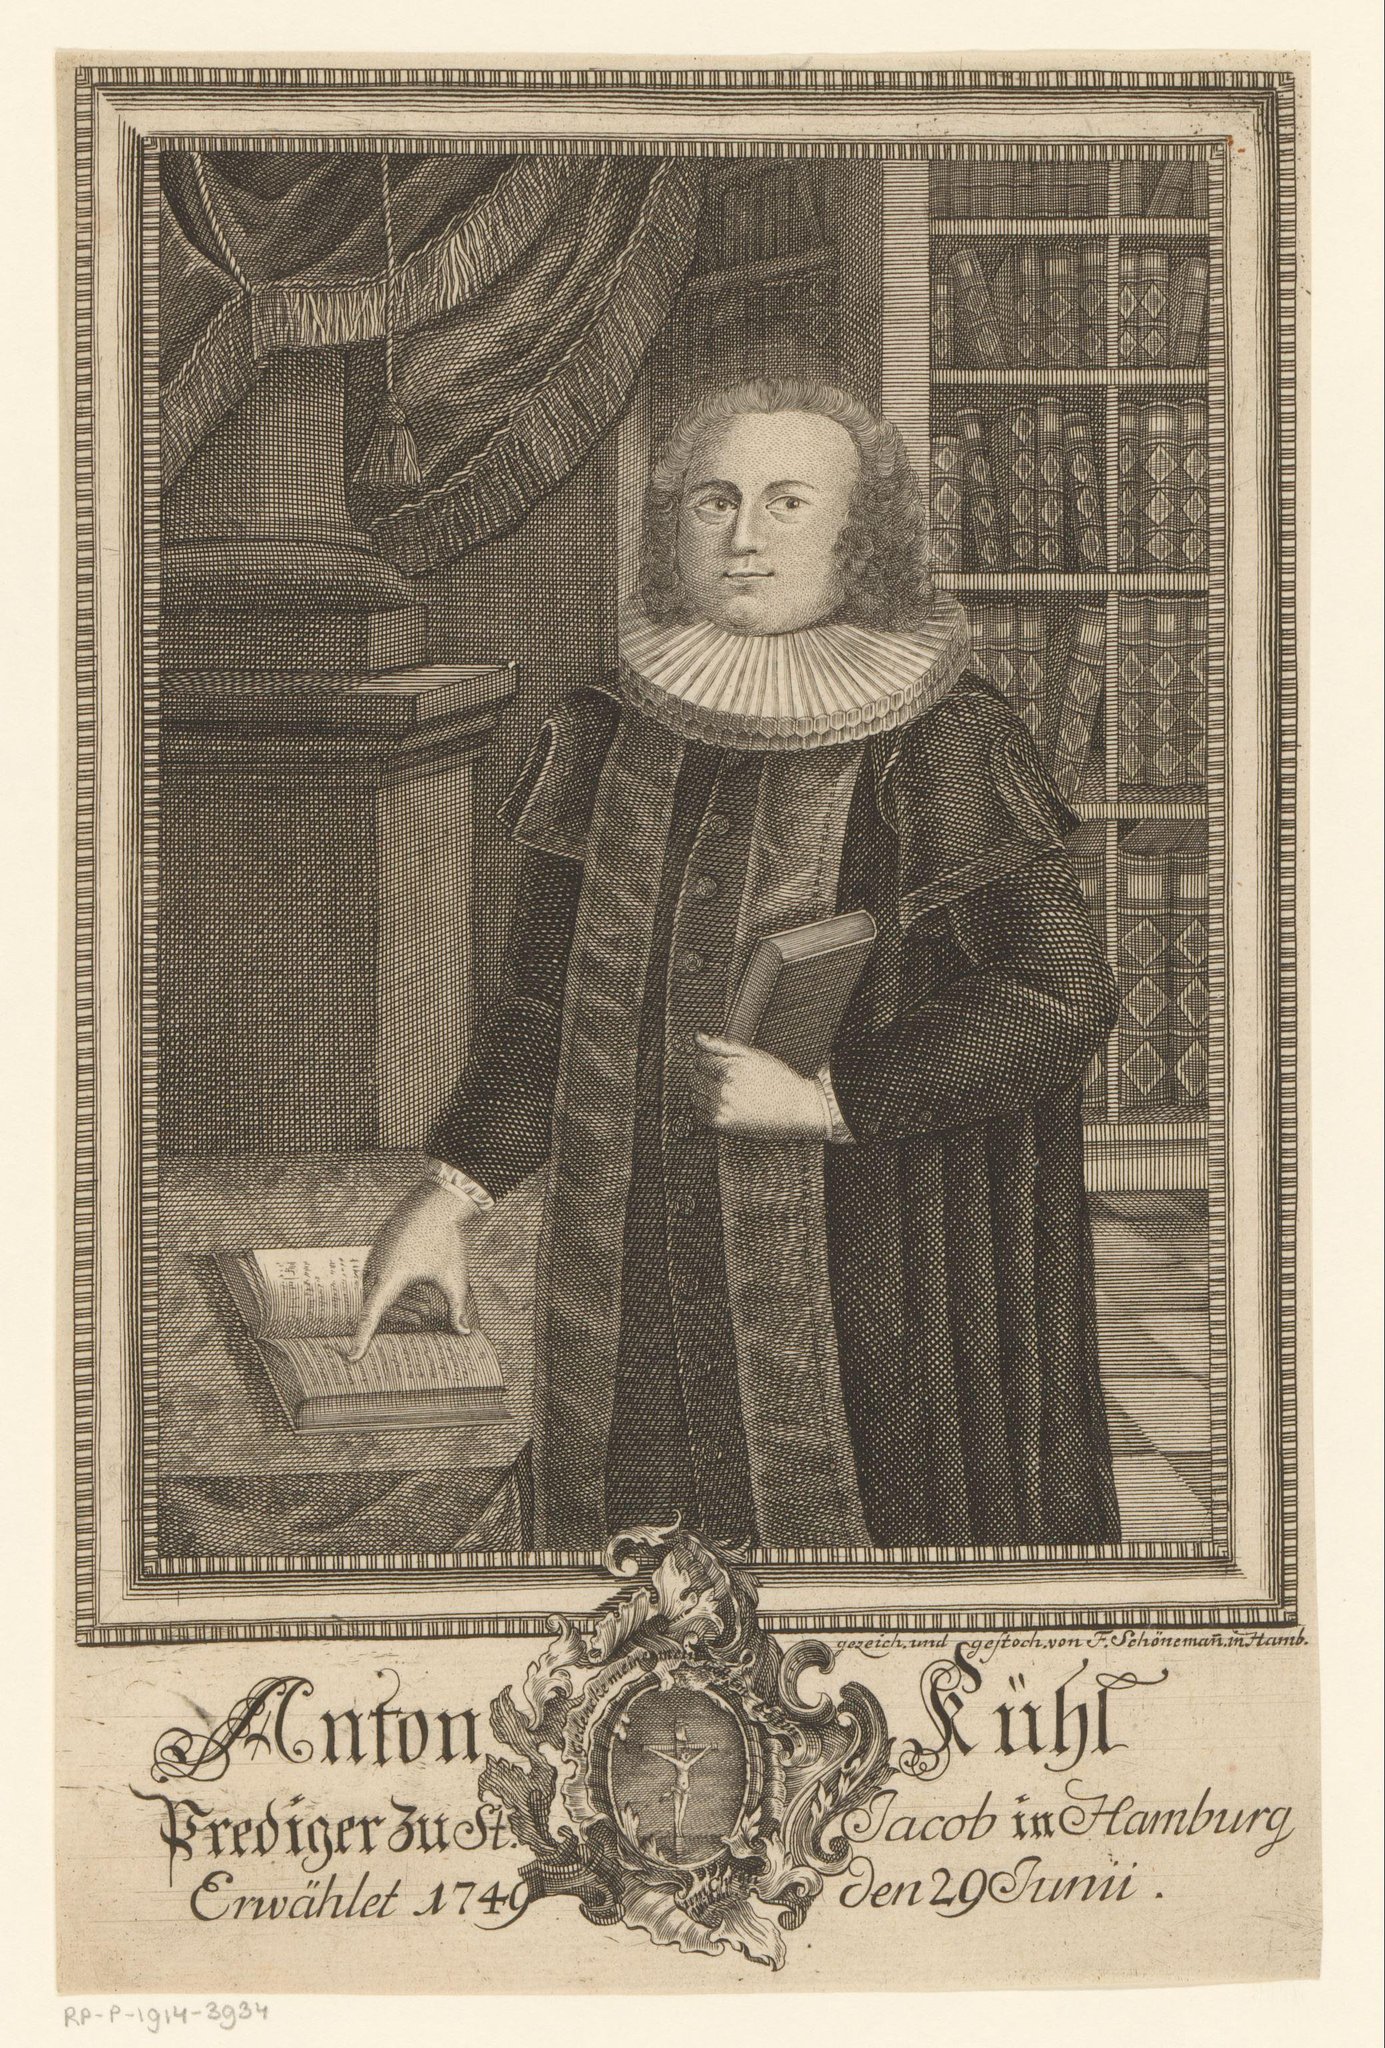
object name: print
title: Portret van Anton Kühl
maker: friedrich schoenemann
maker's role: print maker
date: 1749-1760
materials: paper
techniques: engraving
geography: hamburg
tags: historical persons, book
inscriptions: collector's mark: Lugt 2228